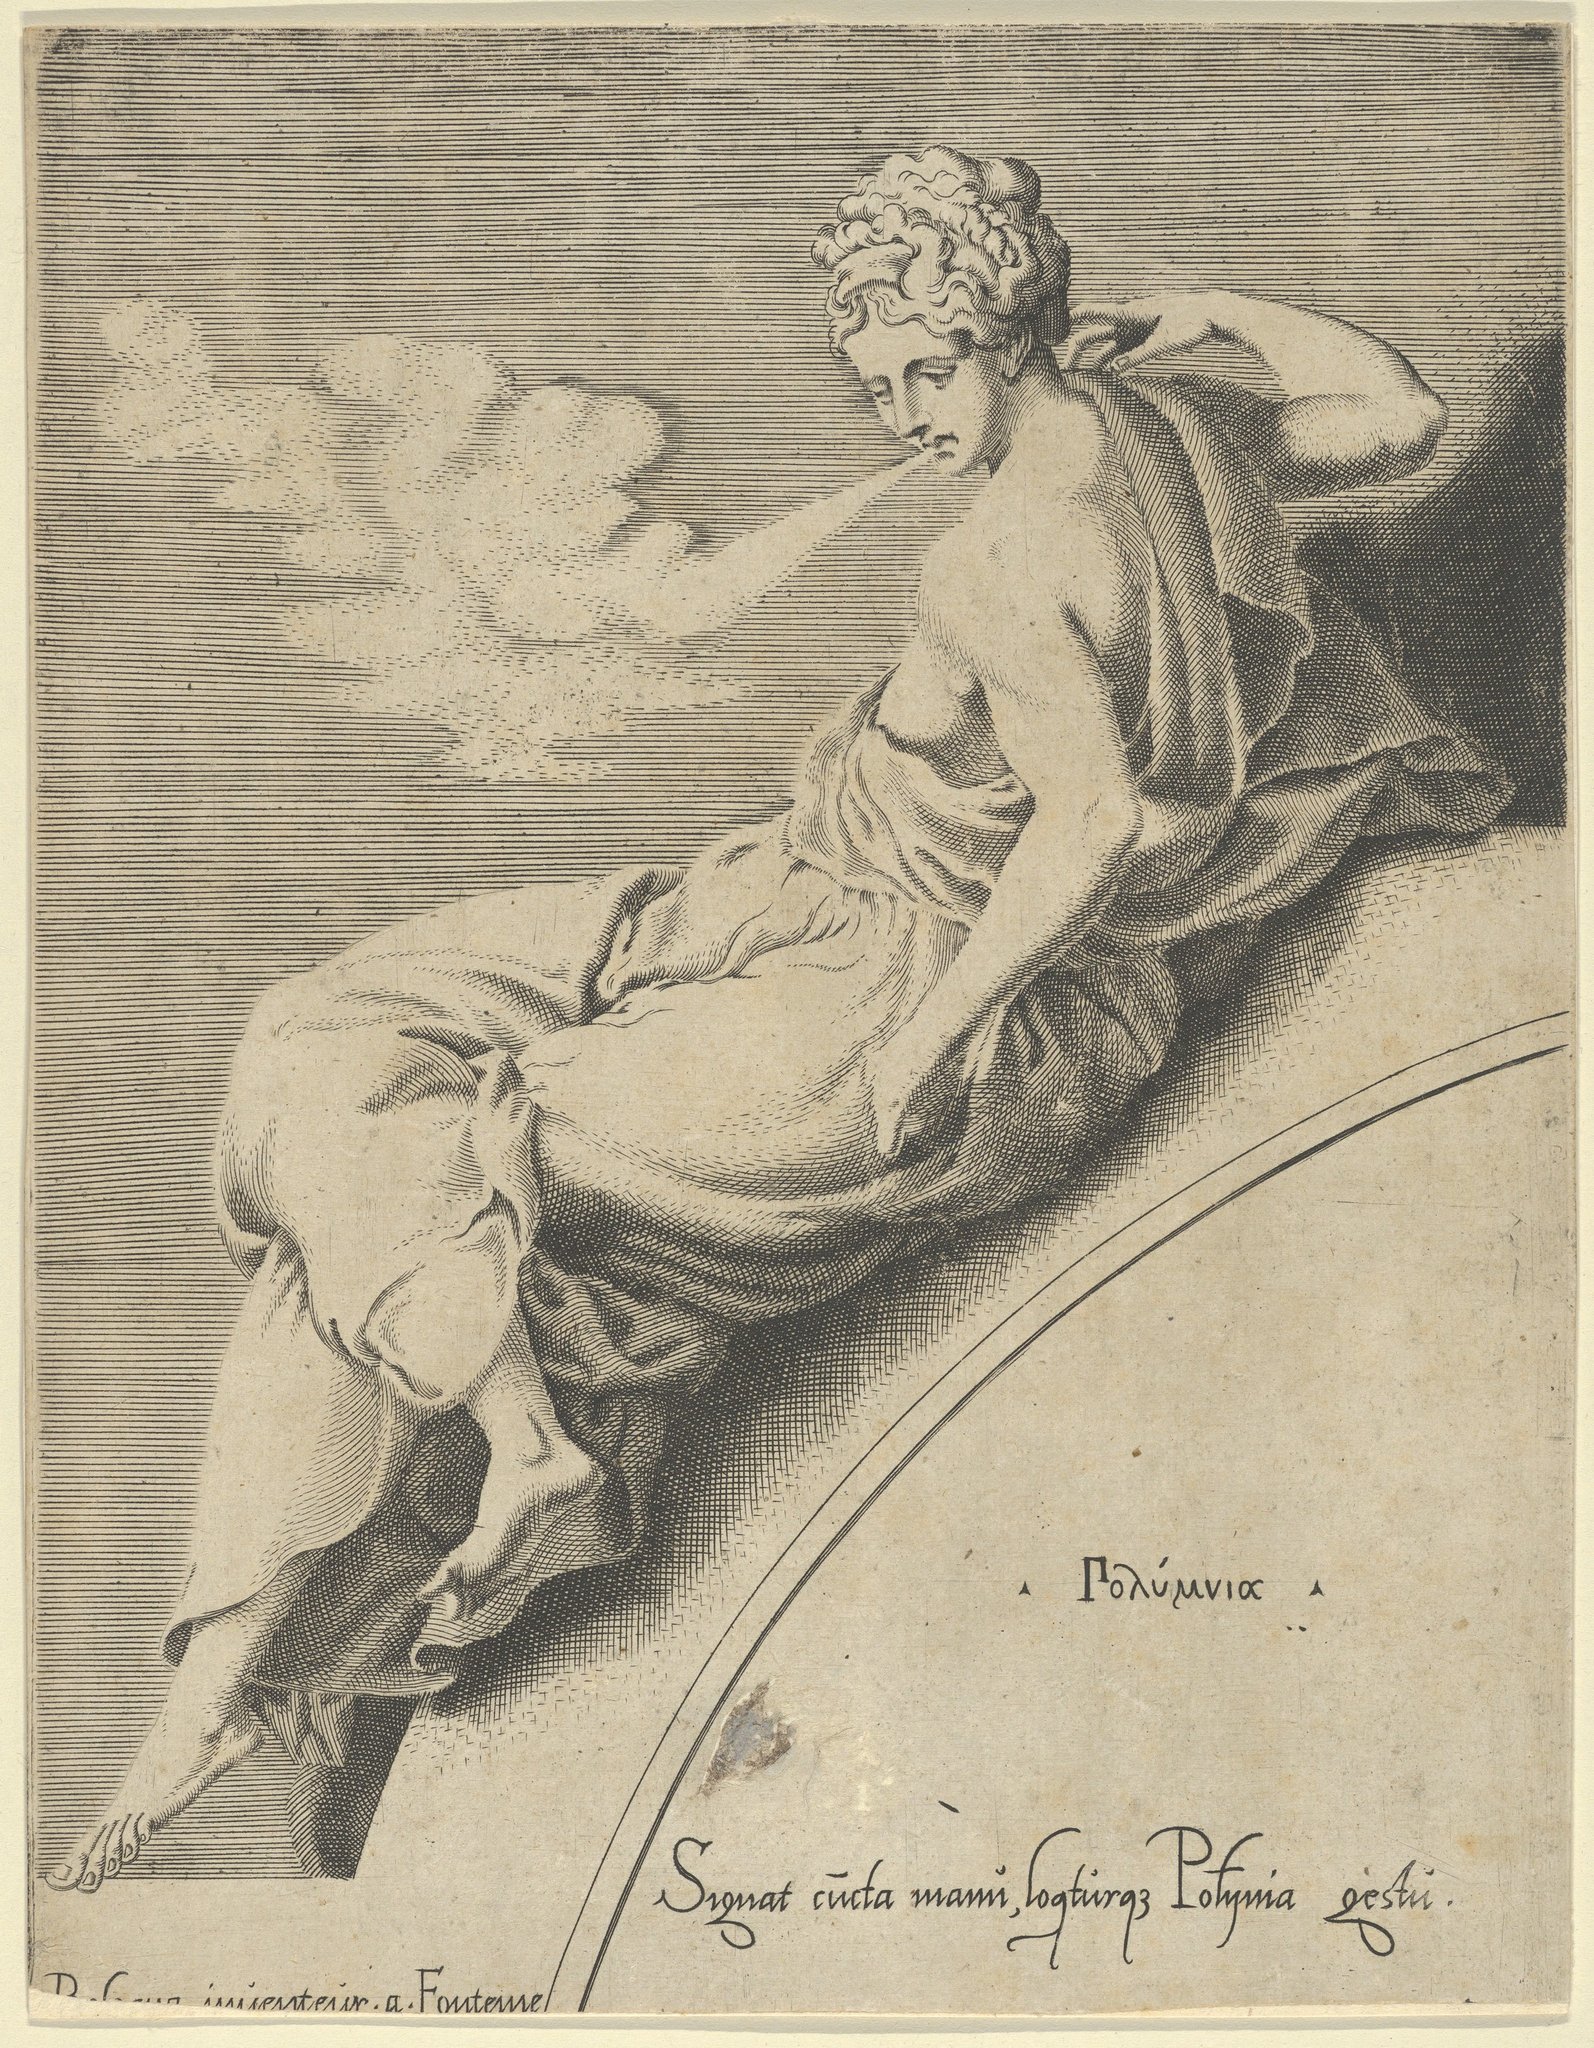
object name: print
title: Polyhymnia, from "The Muses and the Three Great Goddesses"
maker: anonymous, italian, 16th century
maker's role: artist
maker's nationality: italian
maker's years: 1550-1600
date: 1540-1545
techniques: engraving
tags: muses